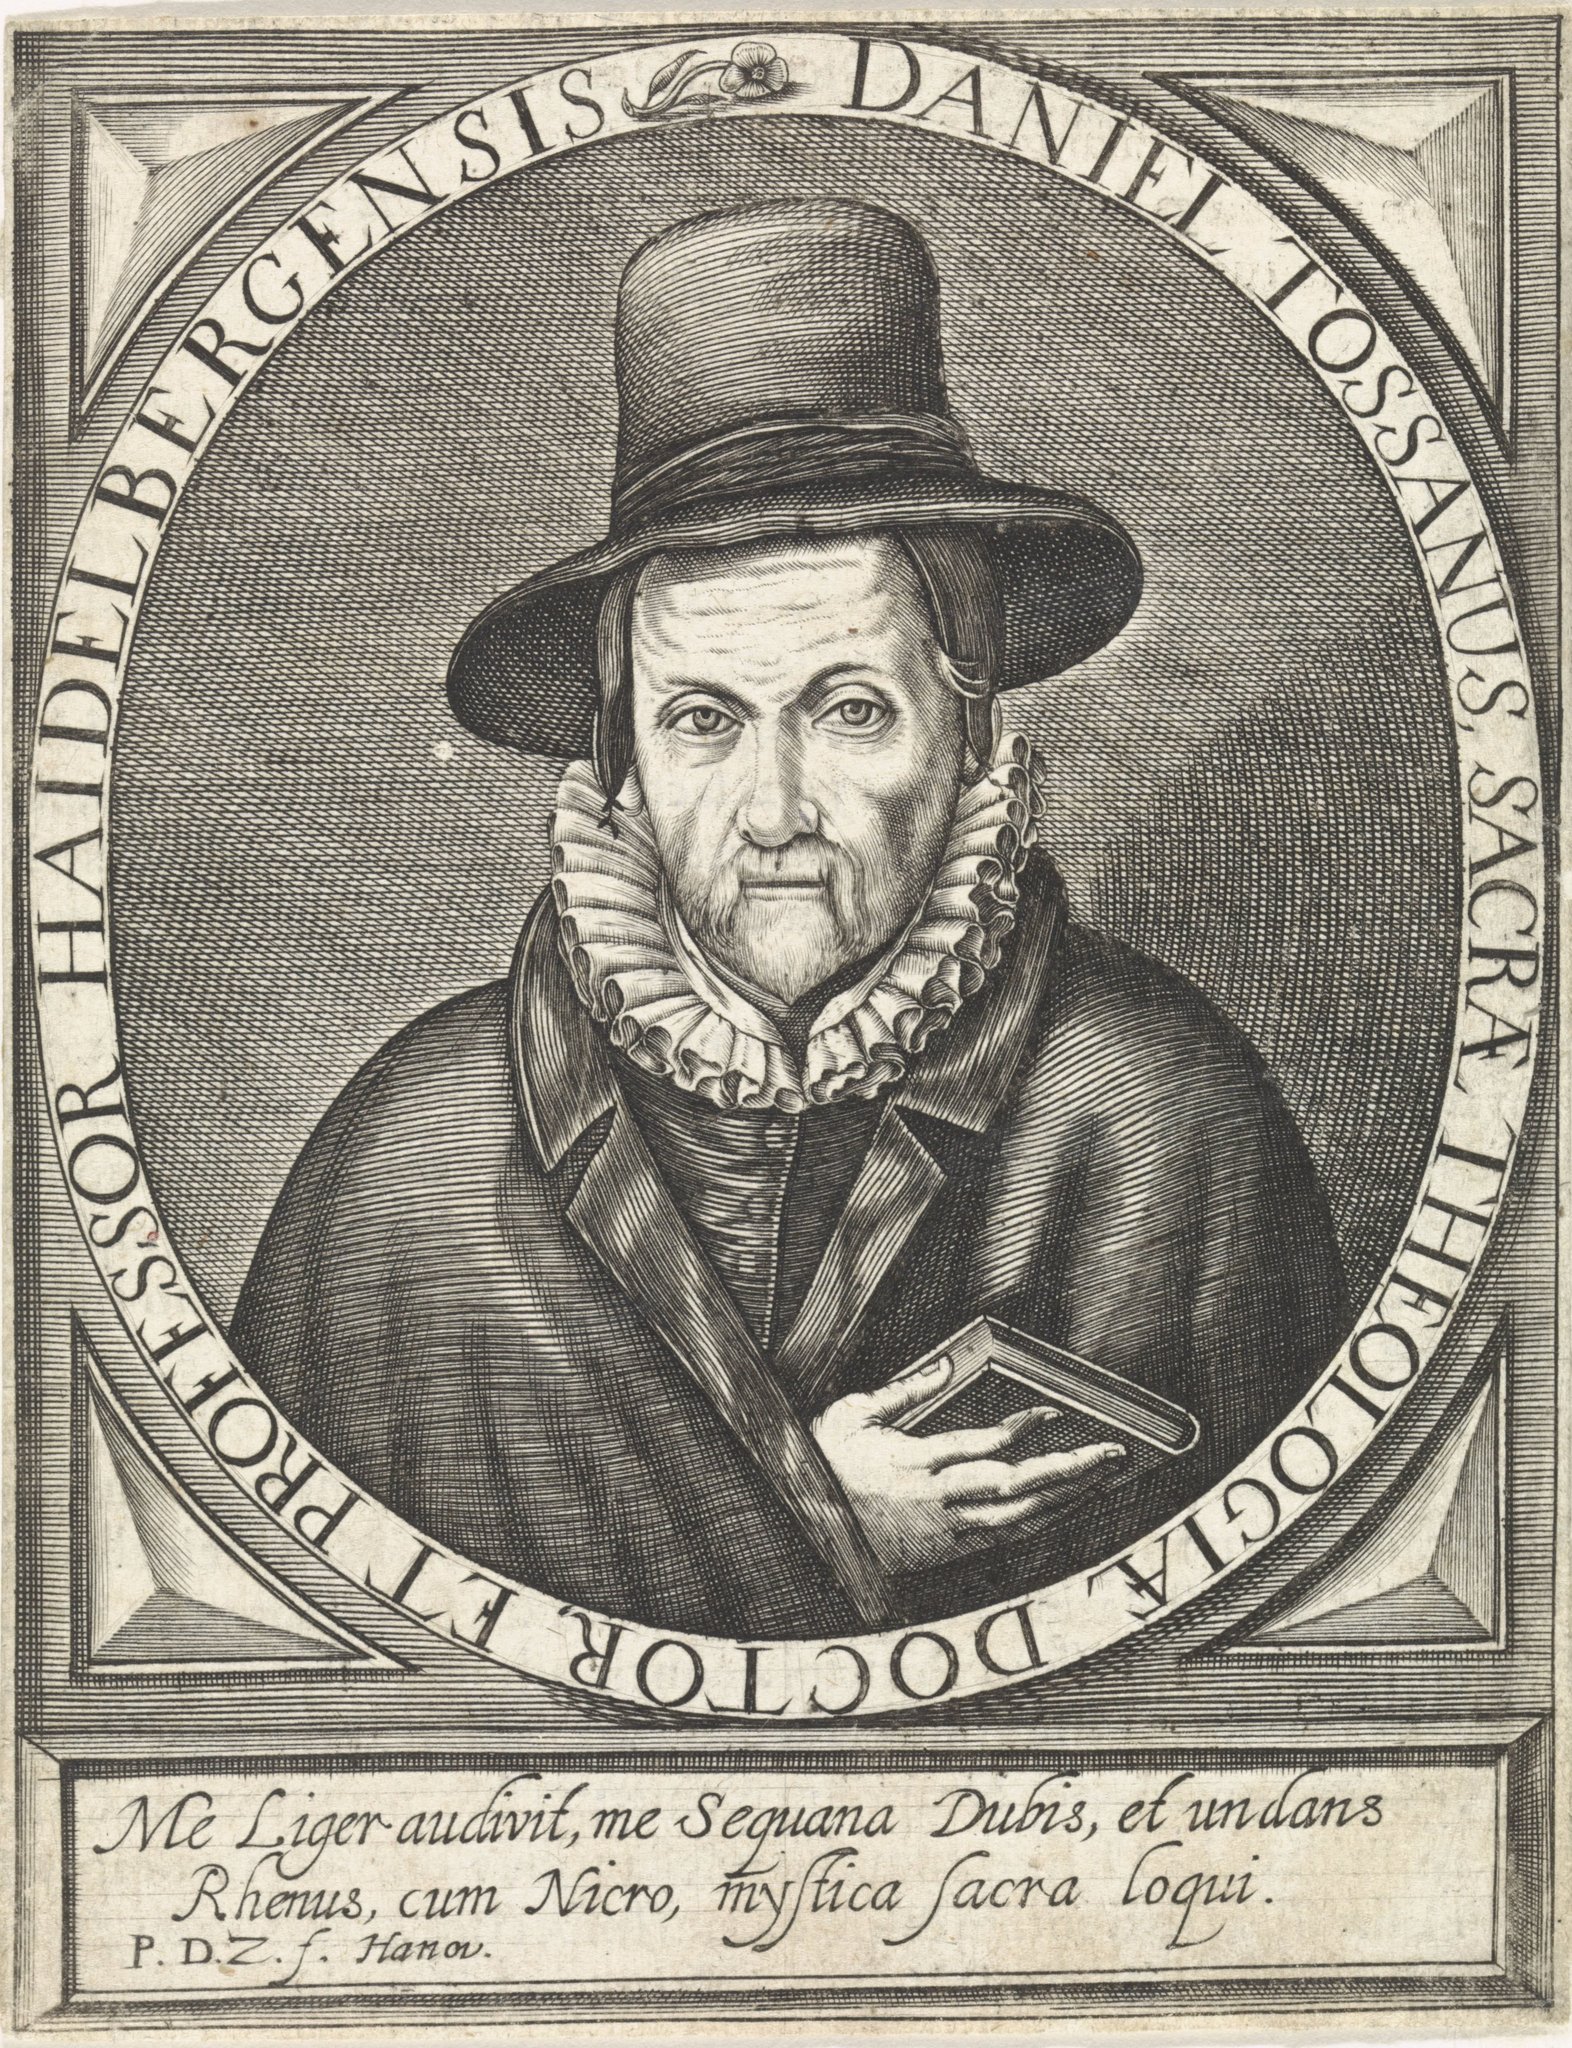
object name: book illustration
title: Portretten van beroemde Europese wetenschappers, humanisten en geestelijken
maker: paul de zetter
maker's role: print maker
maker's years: 1600-1667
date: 1622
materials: paper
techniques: engraving, letterpress printing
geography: hanau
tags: head-gear: hat (+ men's clothes)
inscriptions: collector's mark: Lugt 2228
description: Prent gebruikt in een van de edities van Jean-Jacques Boissard. Boissard, Jean-Jacques. Bibliotheca sive Thesaurus Virtutis et Gloriae: In quo continentus Illvstrivm Ervditione & doctrina Virorum Effigies & Vitae (...). Frankfurt, [1628]. Zie Hollstein Dutch, deel LVIII, p. 86-87.